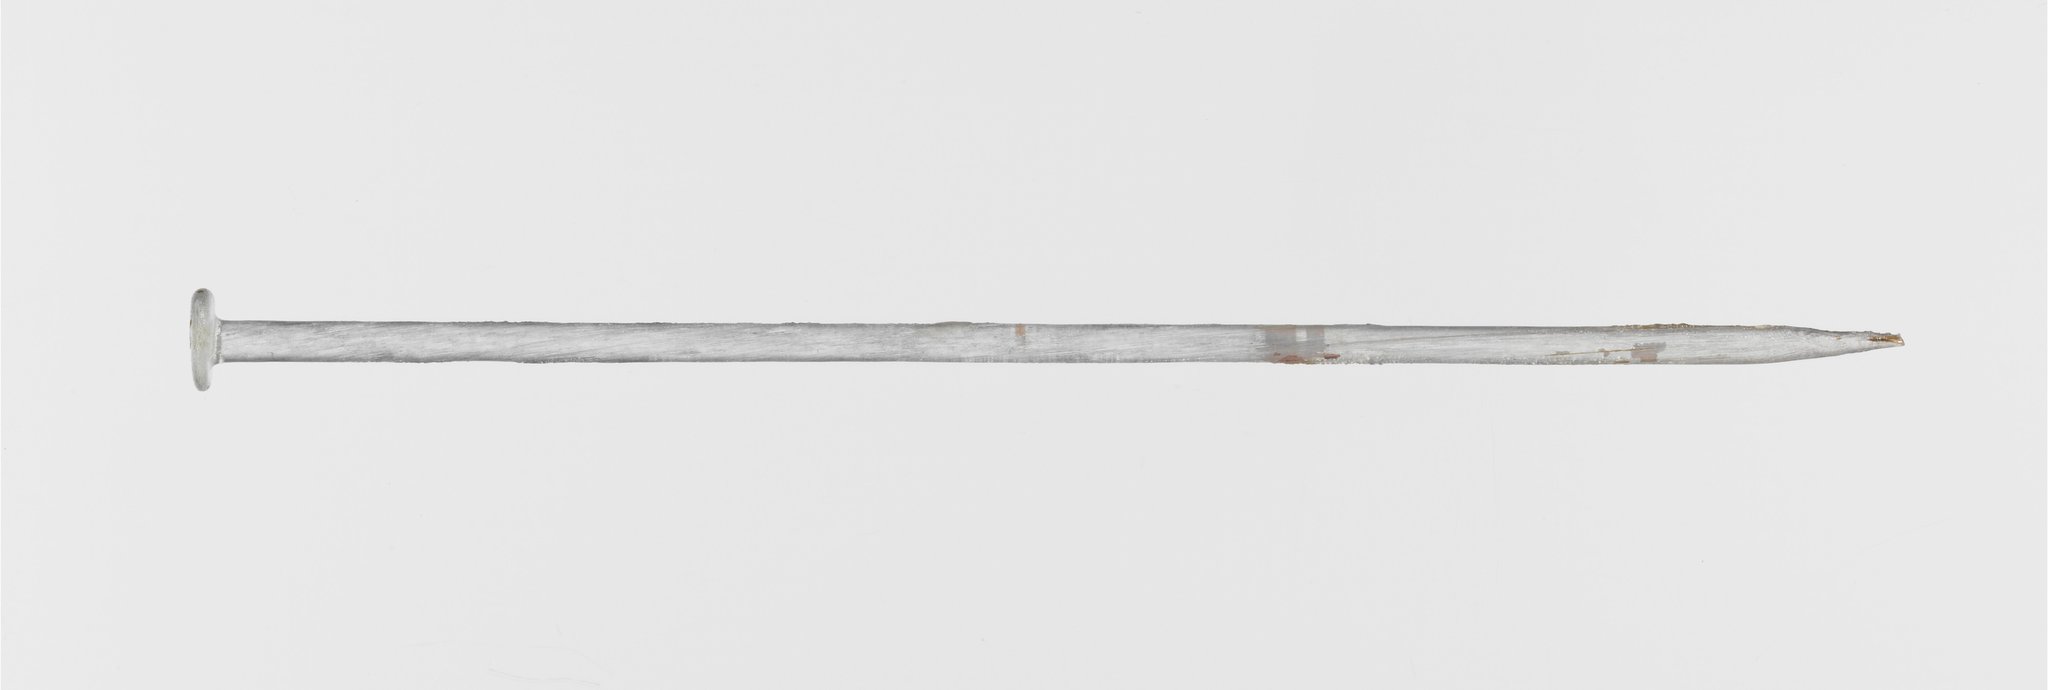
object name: pin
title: Glass pin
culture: roman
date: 1-100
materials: glass